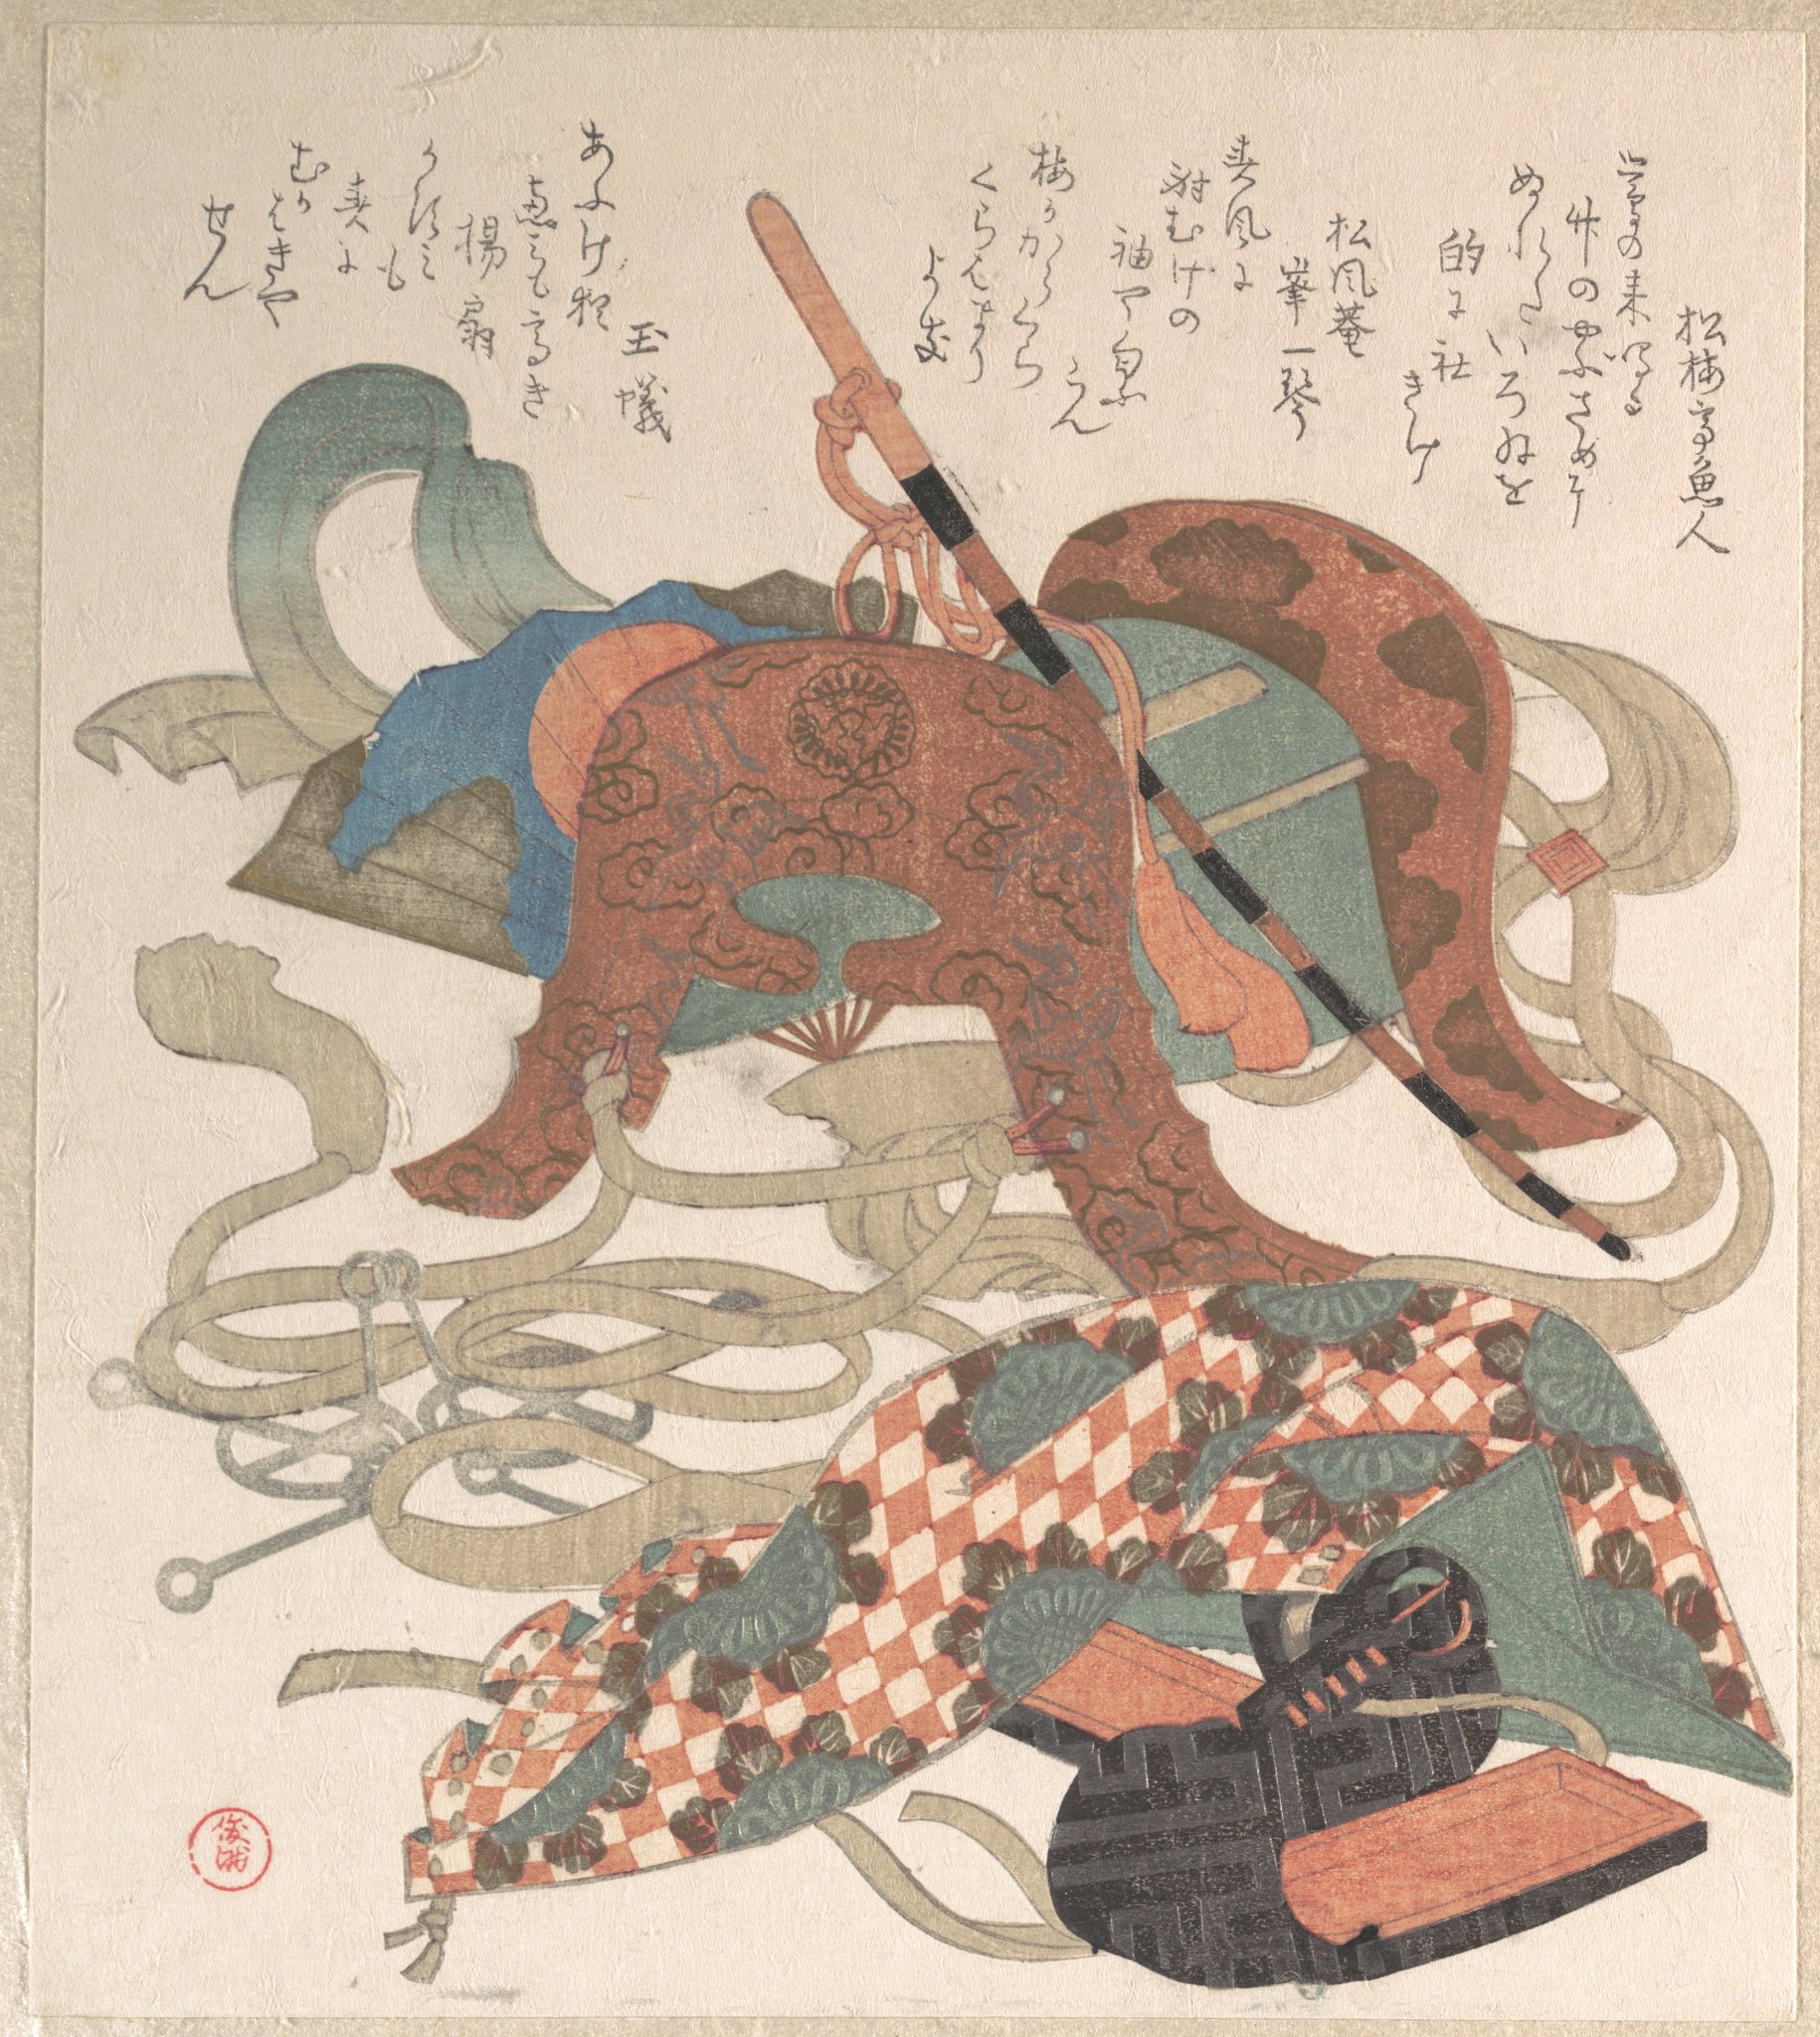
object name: print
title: Saddle and Other Pieces of Harness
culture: japanese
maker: kubo shunman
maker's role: artist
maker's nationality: japanese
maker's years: 1757-1820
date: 1810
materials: ink, paper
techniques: surimono, woodblock print